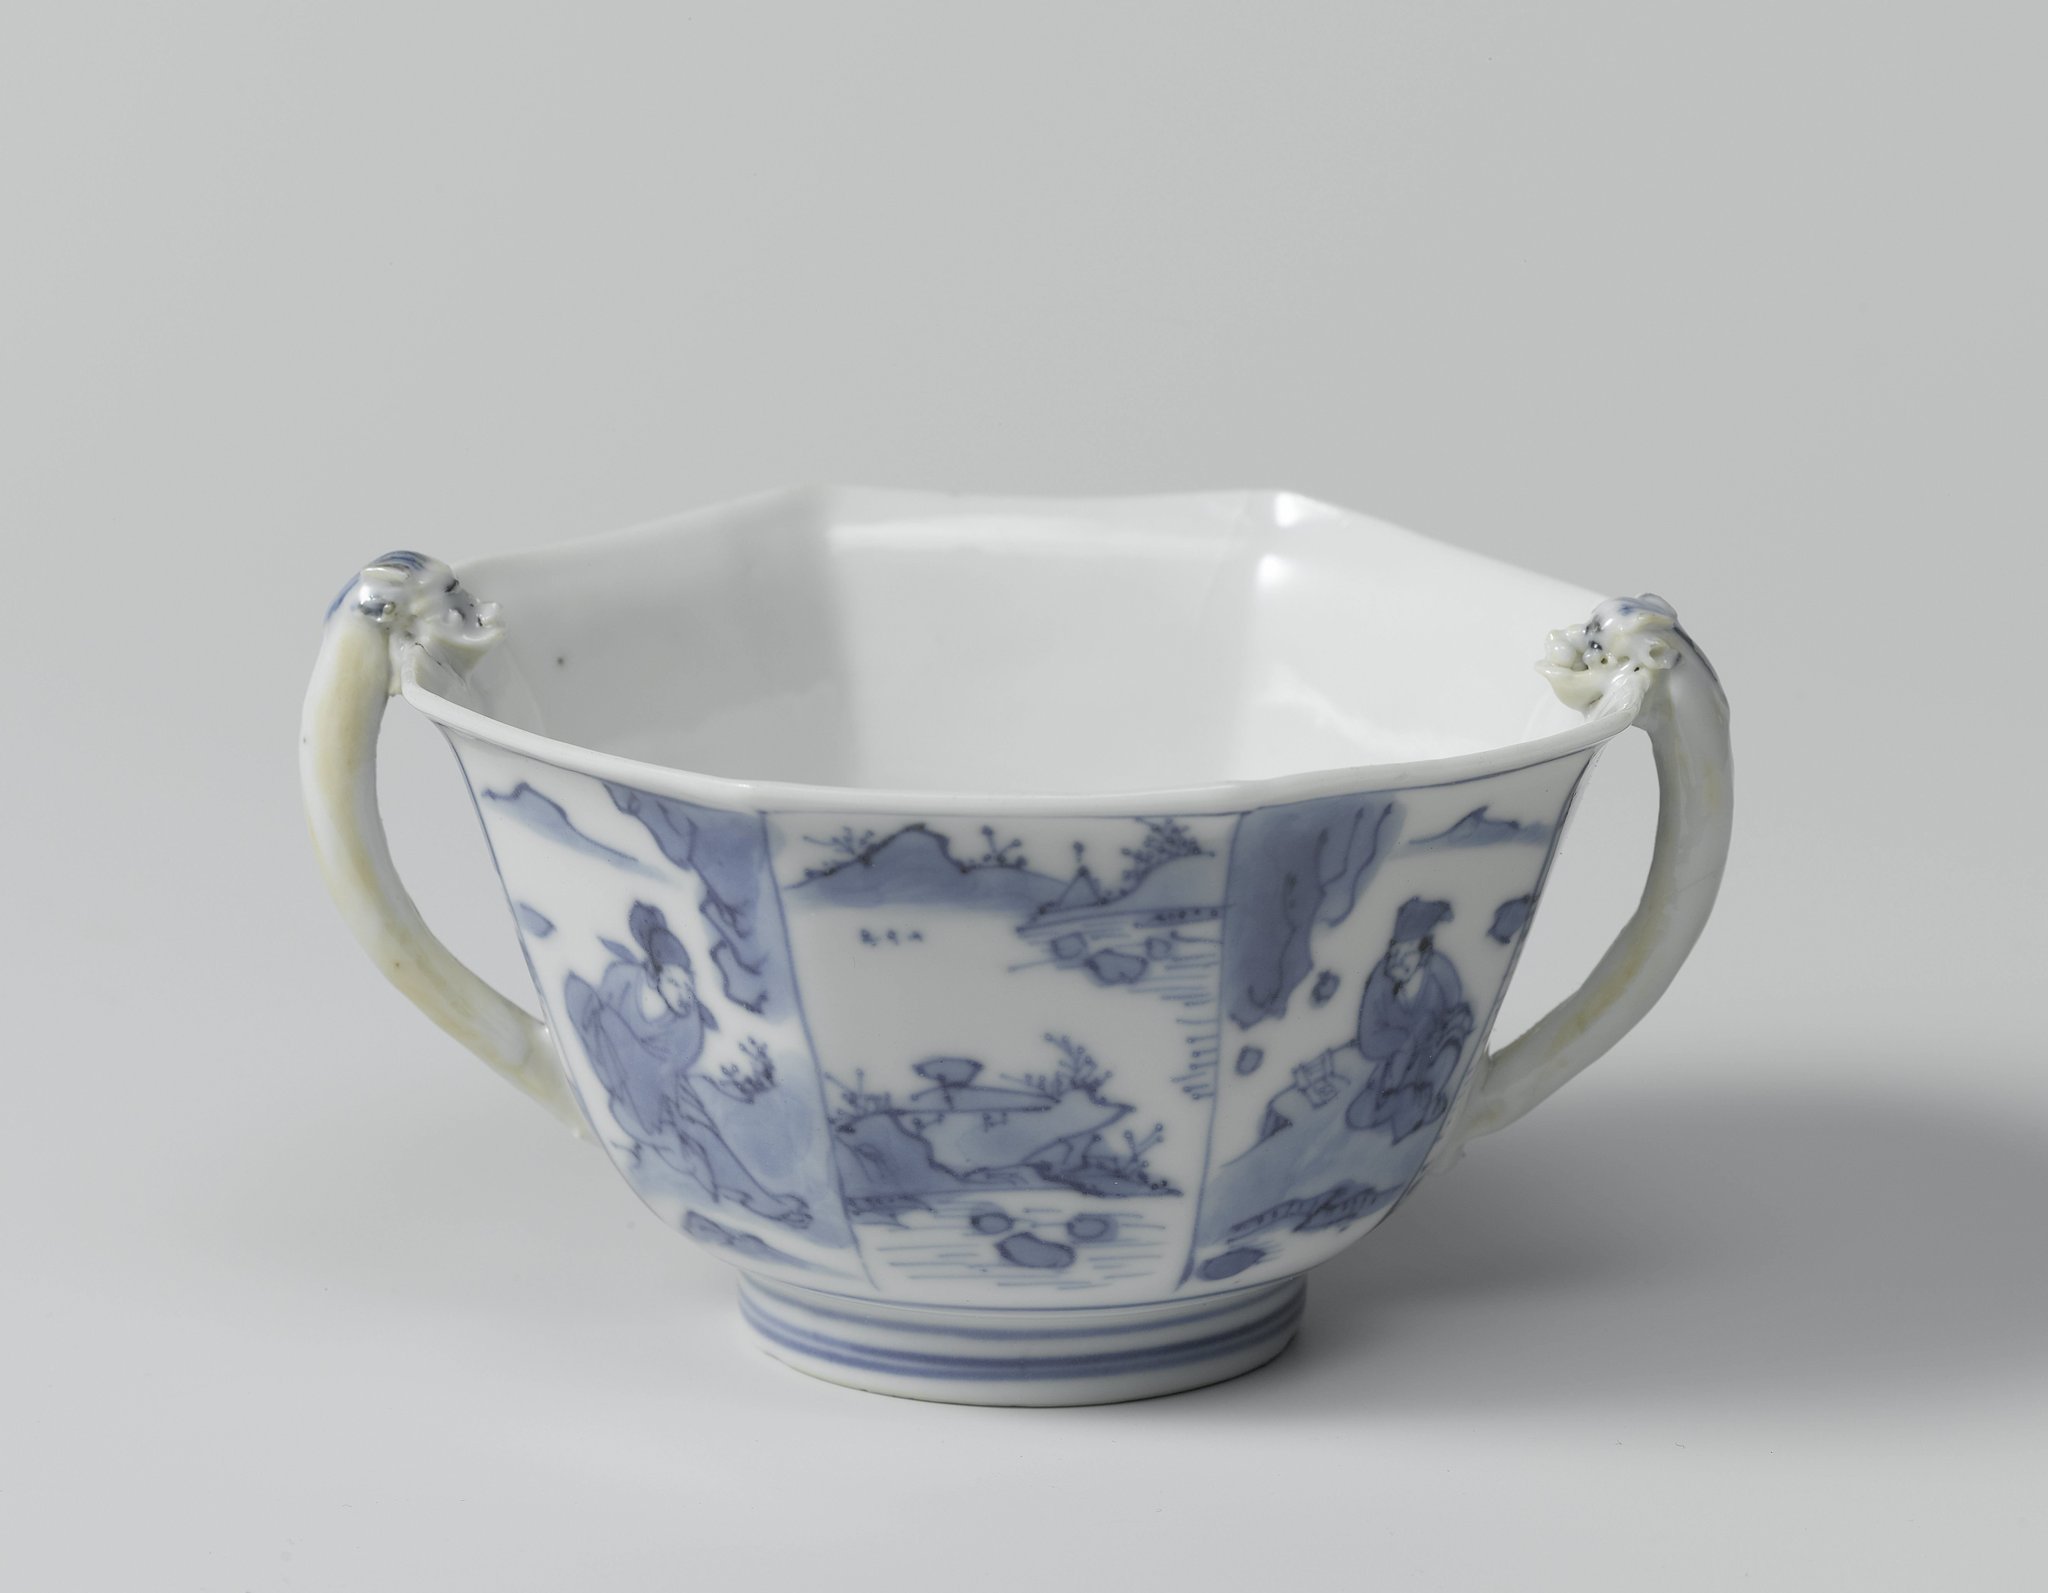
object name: bowl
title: Octagonal bowl with water landscape and scholars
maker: Anonymous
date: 1630-1645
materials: cobalt, glaze, paint, porcelain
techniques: firing, turning, vitrification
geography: china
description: Achthoekige kom van porselein met twee oren waarvan het einde is gemodelleerd in een monsterkop die in de rand van de kom bijt, beschilderd in onderglazuur blauw. De wand is verdeeld in acht vakken met afwisselend een rivierlandschap of een geleerde in een landschap. Overgangsporselein in blauw-wit.